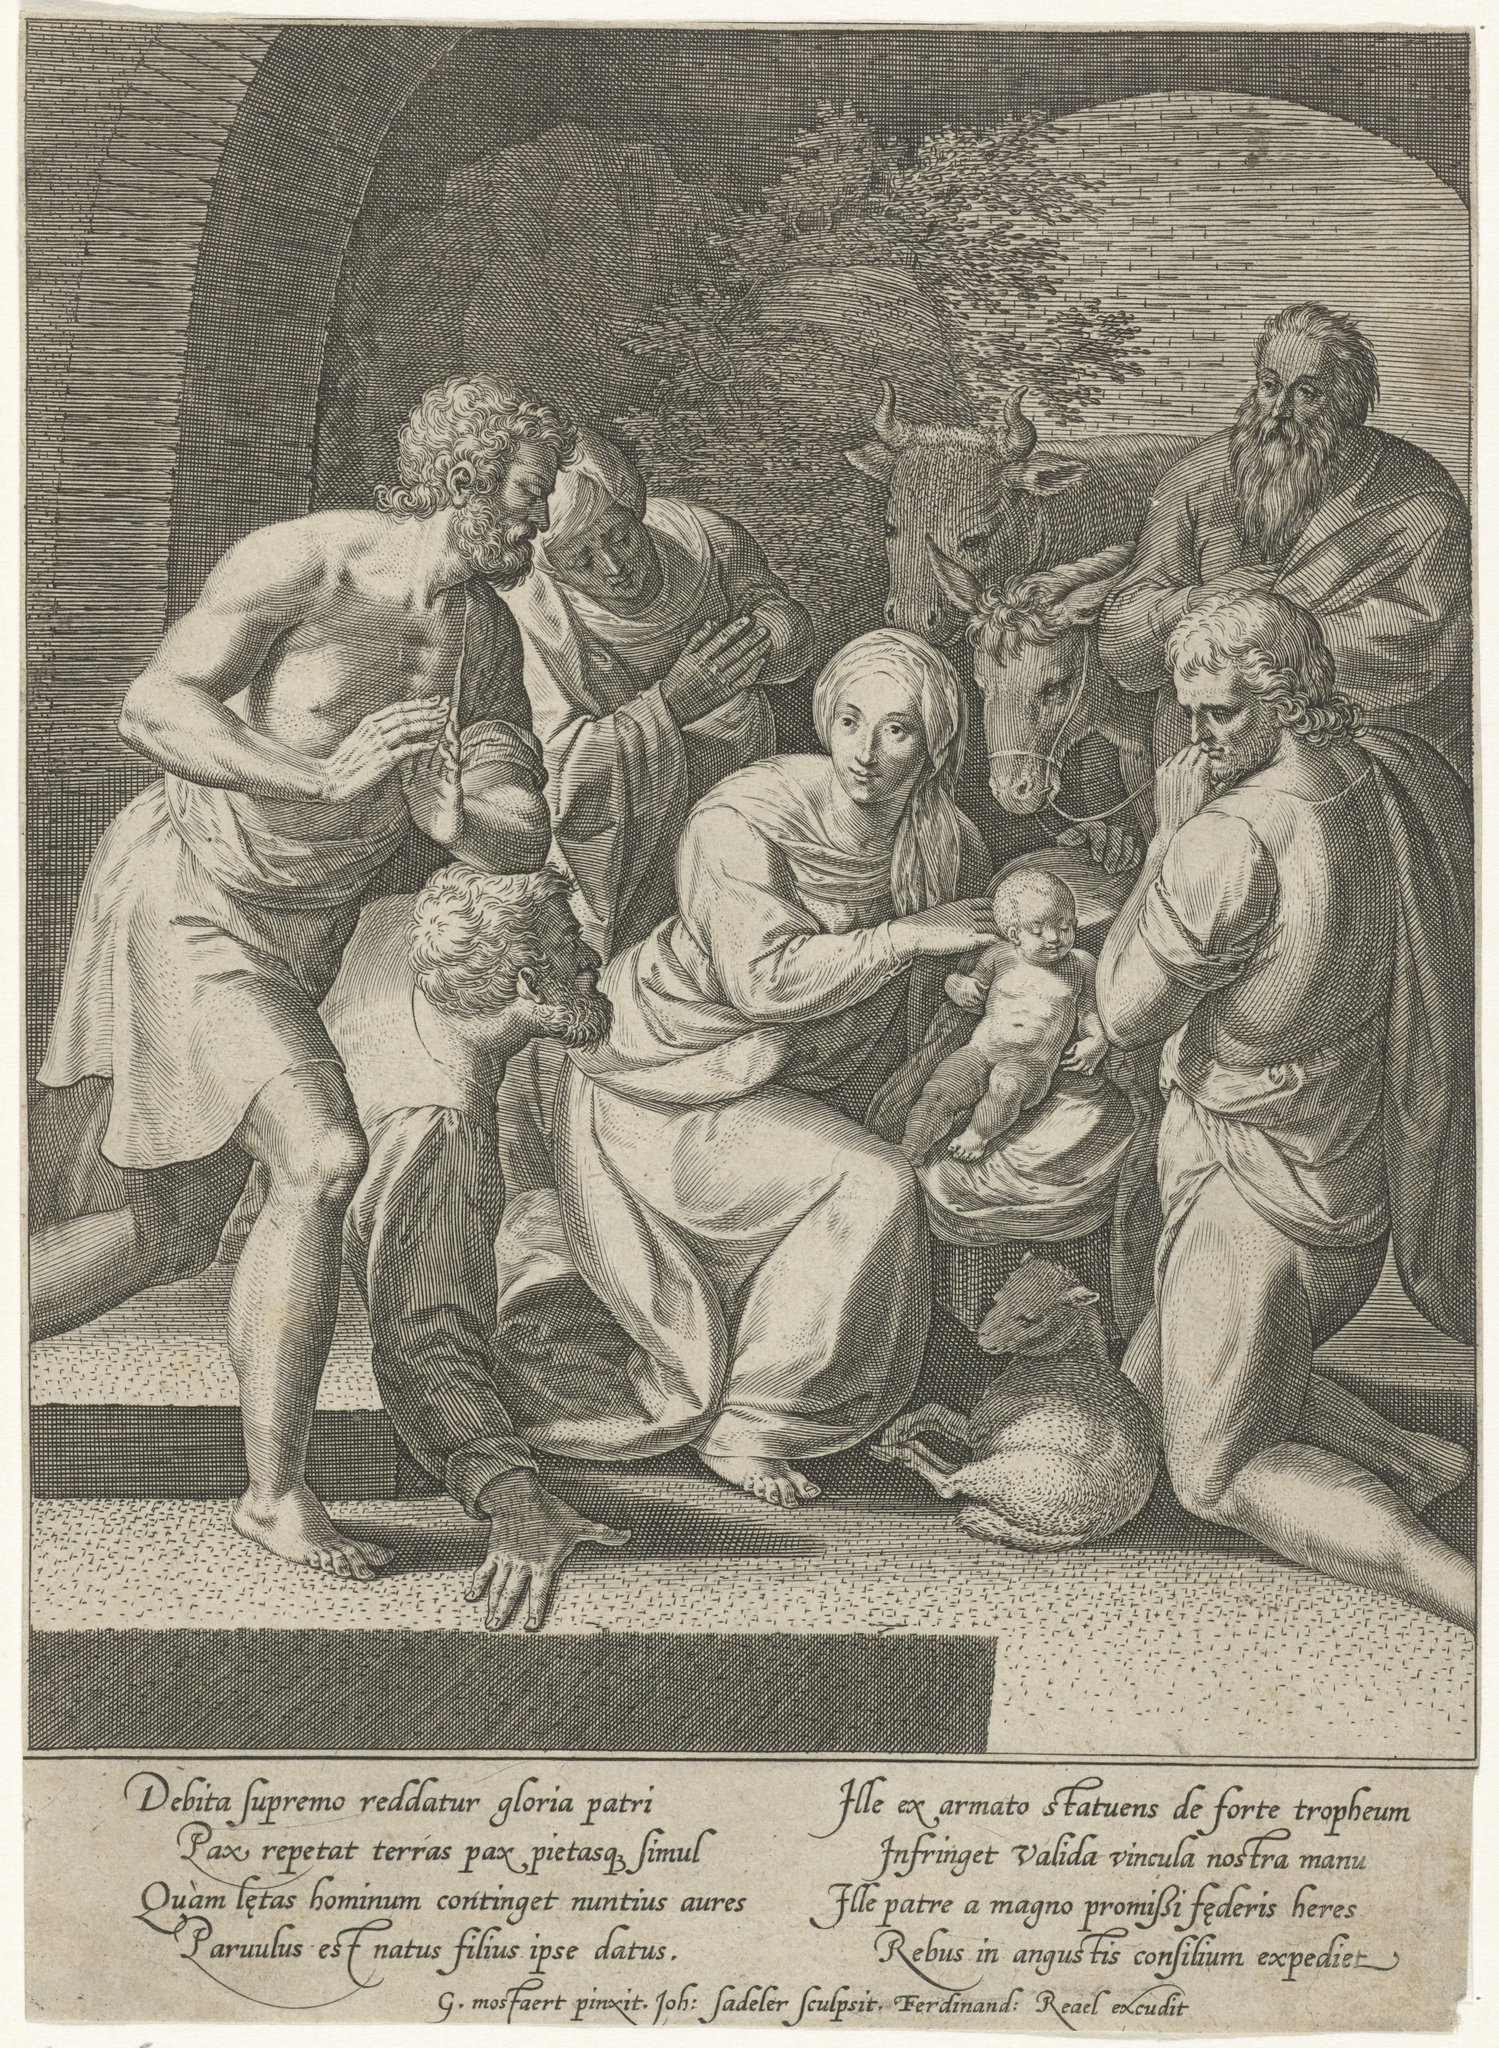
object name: print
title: Aanbidding der herders in een nis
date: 1560-1600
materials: paper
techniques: engraving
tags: adoration of the christ-child by the shepherds; mary and joseph present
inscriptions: collector's mark: Lugt 240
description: In het midden van een nis zit Maria naast het Christuskind dat in de kribbe ligt. Achter Maria staat Jozef en de os en de ezel. Herders knielen voor het Christuskind. De prent heeft een Latijnse tekst als onderschrift.